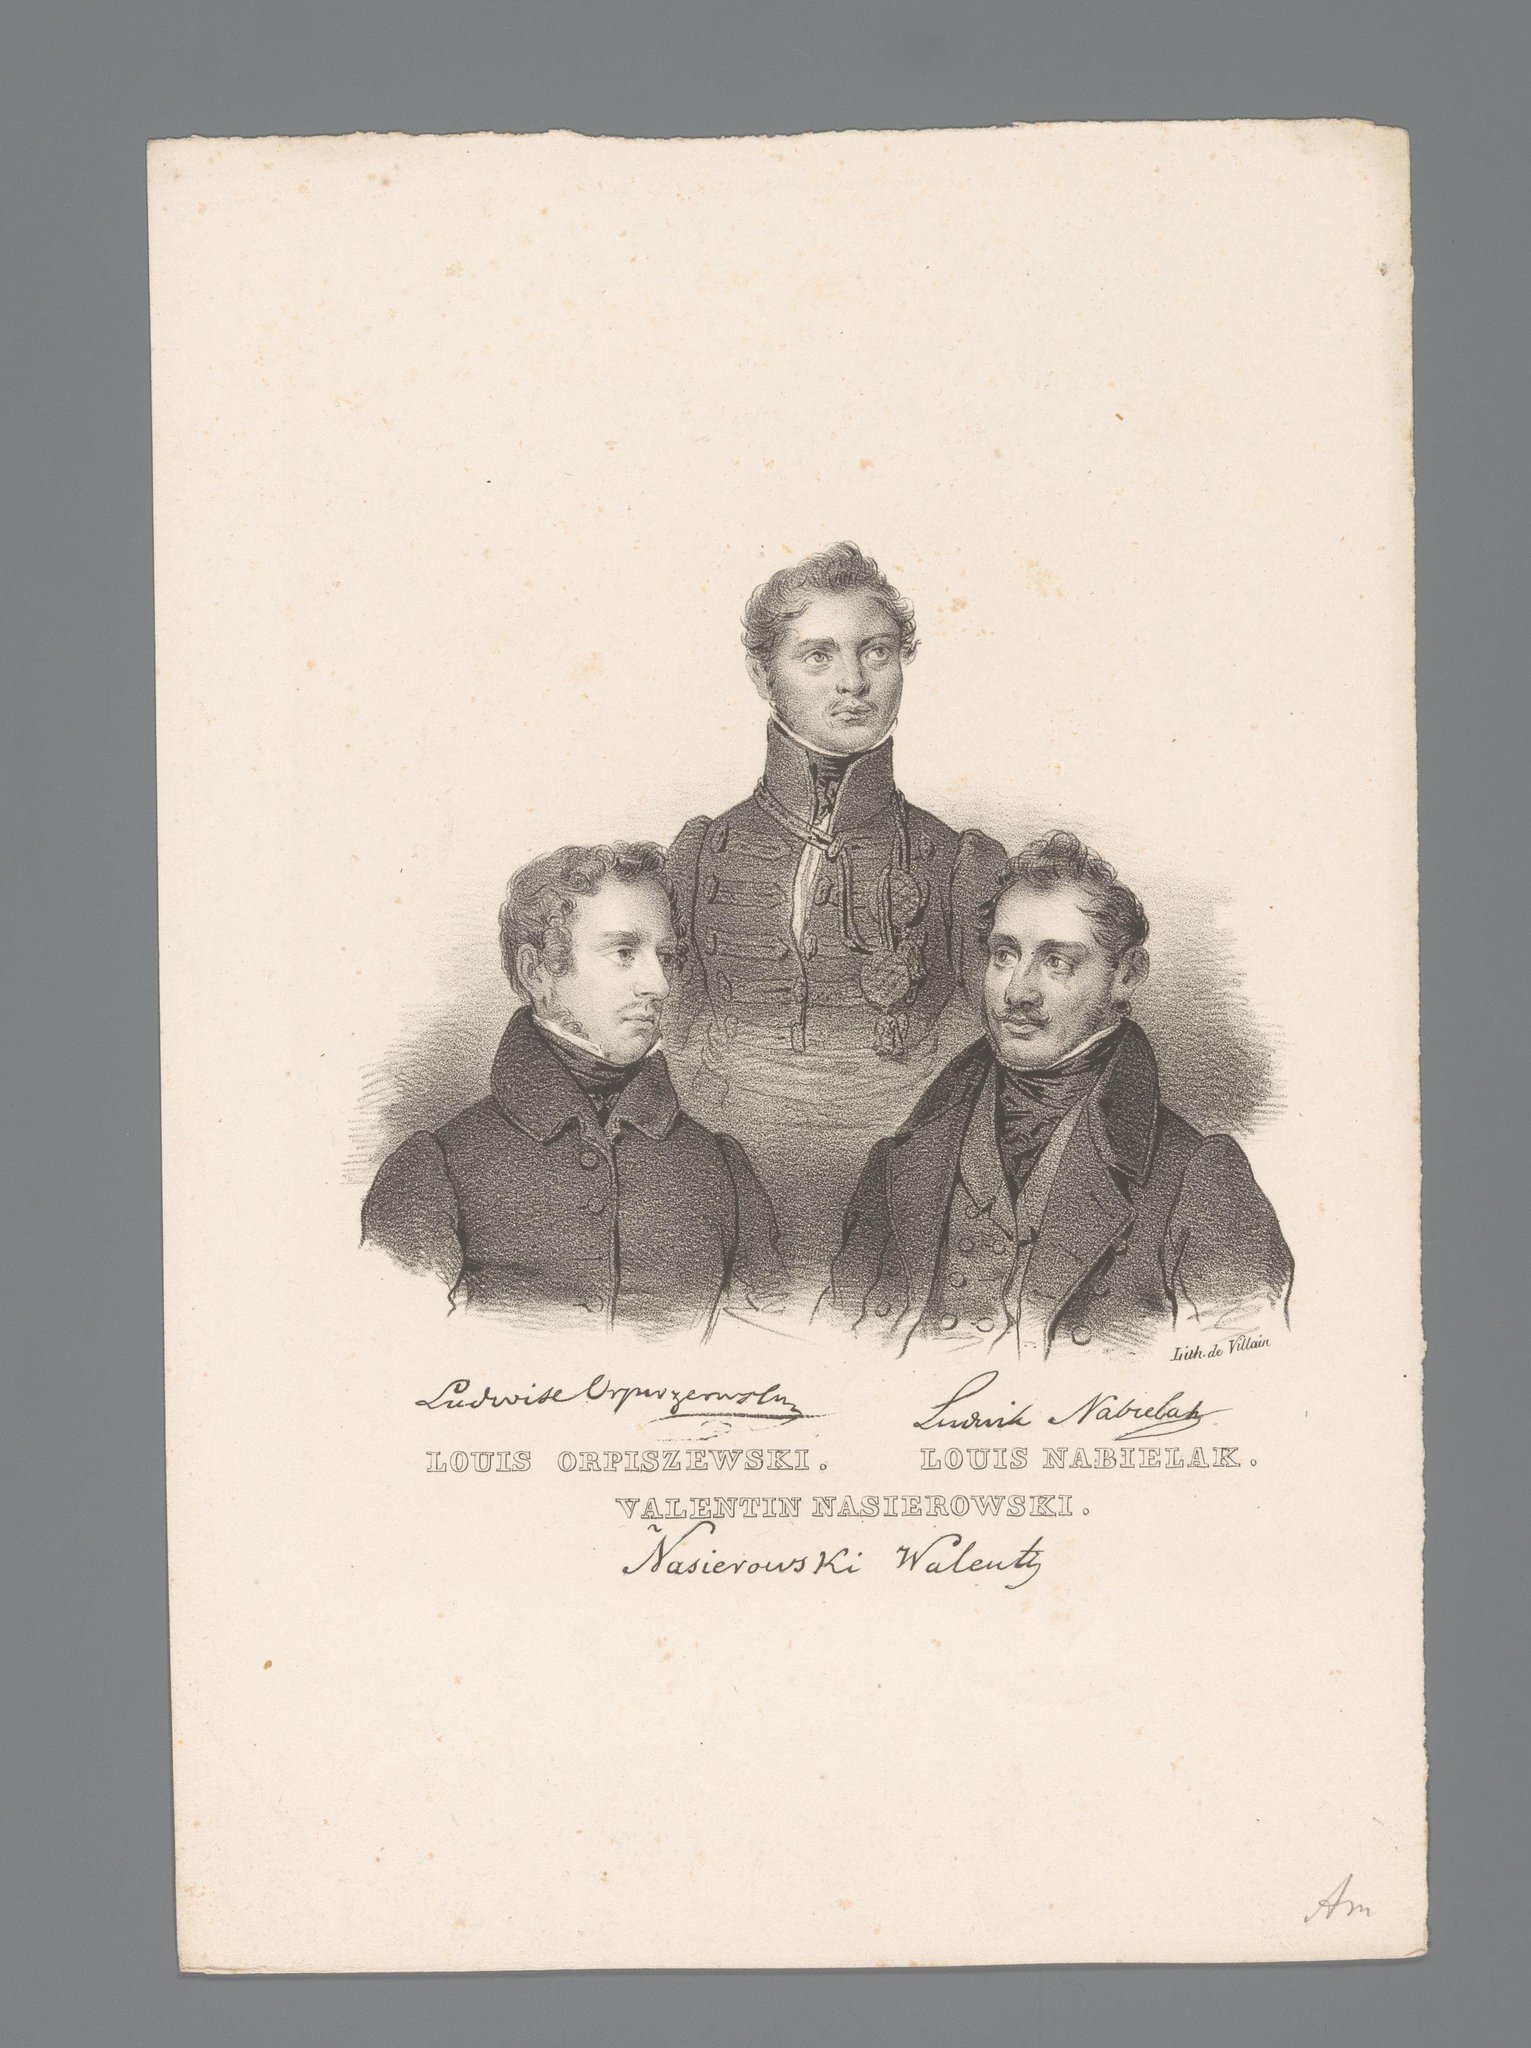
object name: print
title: Portretten van drie deelnemers aan de Poolse Novemberopstand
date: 1832-1839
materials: paper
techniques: lithograph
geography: paris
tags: switzerland, paris, historical persons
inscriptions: collector's mark: Lugt 2228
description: Prent uit: Straszewicz., Joseph. Les polonais et les polonaises de la révolution du 29 novembre 1830, ou Portraits des personnes qui ont figuré dans la dernière guerre de l'indépendance polonaise, avec les fac-simile de leur signature, lithographiés sur dessins originaux, par les artistes les plus distingués: MM. Grévedon, Maurin, Vigneron, Belliard, Devéria, Bazin, Desmadryl, Lecler, Desmaisons, Rutowski, officier polonais, etc,. etc., accompagnés d'une biographie pour chaque portrait. Parijs: Catherine-Anaïs Pinard, 1832. Of uit: Straszewicz., Joseph. Les polonais et les polonaises de la révolution du 29 novembre 1830. Biographie des personnes qui ont figuré dans la dernière guerre de l'indépendance polonaise, avec les fac-simile de leur signature, ornée de 30 portraits lithographiés sur dessins originaux, par les artistes les plus distingués: MM. Grévedon, Maurin, Vigneron, Belliard, Devéria, Bazin, Desmadryl, Lecler, etc., etc.. Parijs: s.n., 1839.